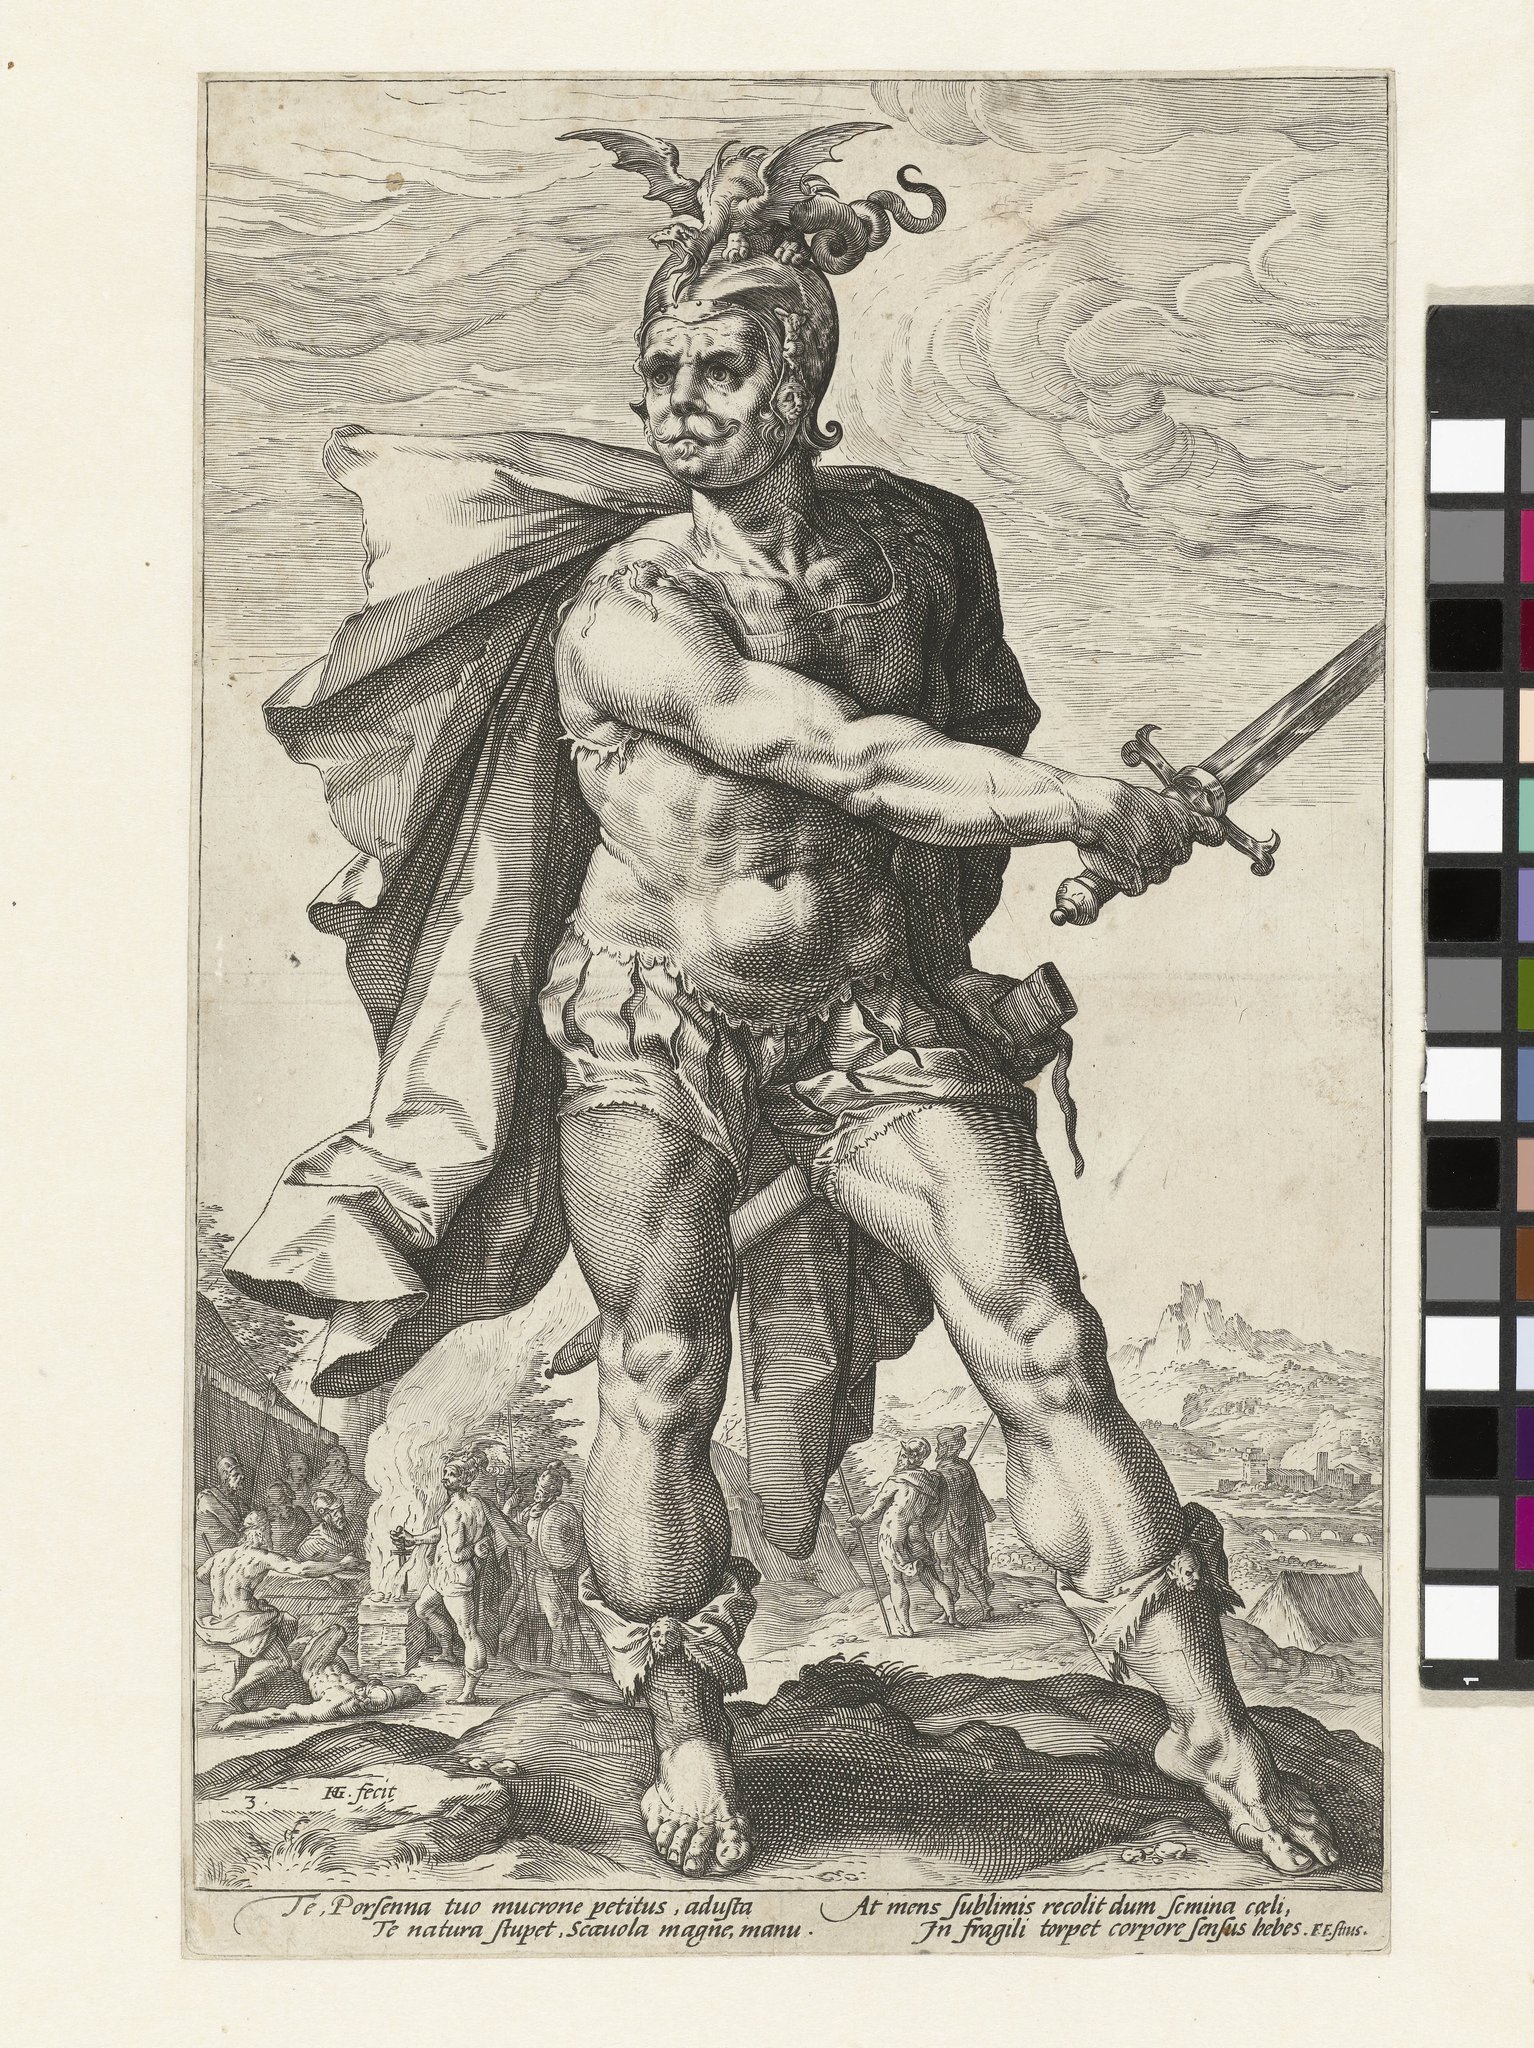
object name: print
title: De Romeinse helden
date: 1586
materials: paper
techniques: engraving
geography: haarlem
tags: gaius mucius scaevola before porsena: he thrusts his right hand into the flames (the body of the king's secretary who erroneously had been killed instead of porsena may be seen lying on the ground)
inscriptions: collector's mark: Lugt 2228a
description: De held Gaius Mucius Scaevola ten voeten uit, een zwaard in de rechterhand, de schede in de linkerhand. Op de achtergrond is te zien hoe hij zijn rechterhand voor koning Porsenna onverschrokken in het vuur steekt. Onder de voorstelling twee maal twee versregels in Latijn. Deze prent is onderdeel van een serie van tien prenten, bestaand uit een ongenummerde titelprent, acht genummerde voorstellingen van helden en een ongenummerde afsluitende prent.